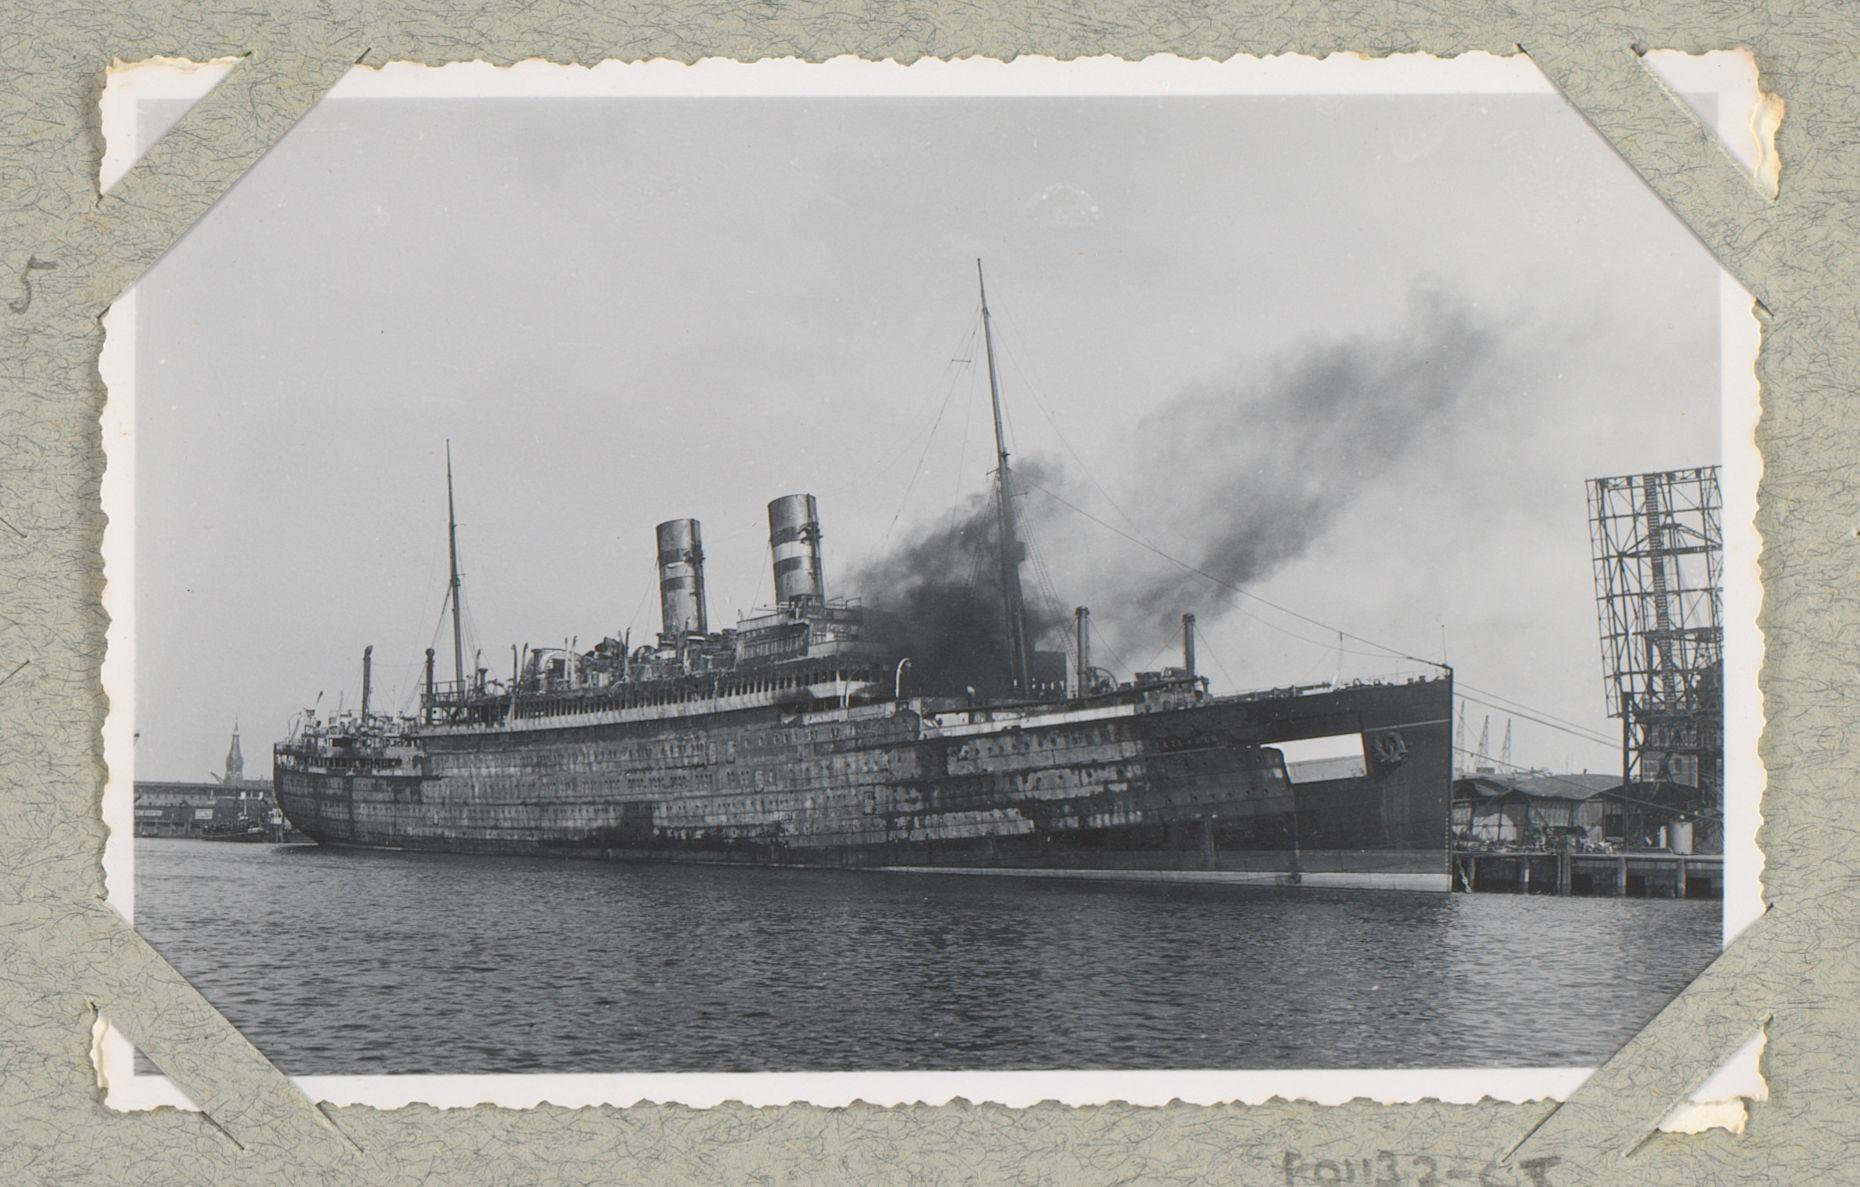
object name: photograph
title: Stoomschip Statendam beschadigd in de haven van Rotterdam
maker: j. nolte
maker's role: fotograaf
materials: photographic support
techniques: gelatin silver print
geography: rotterdam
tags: devastated, ruined place or city (~ warfare), steamship, motorship, rotterdam, rotterdam blitz